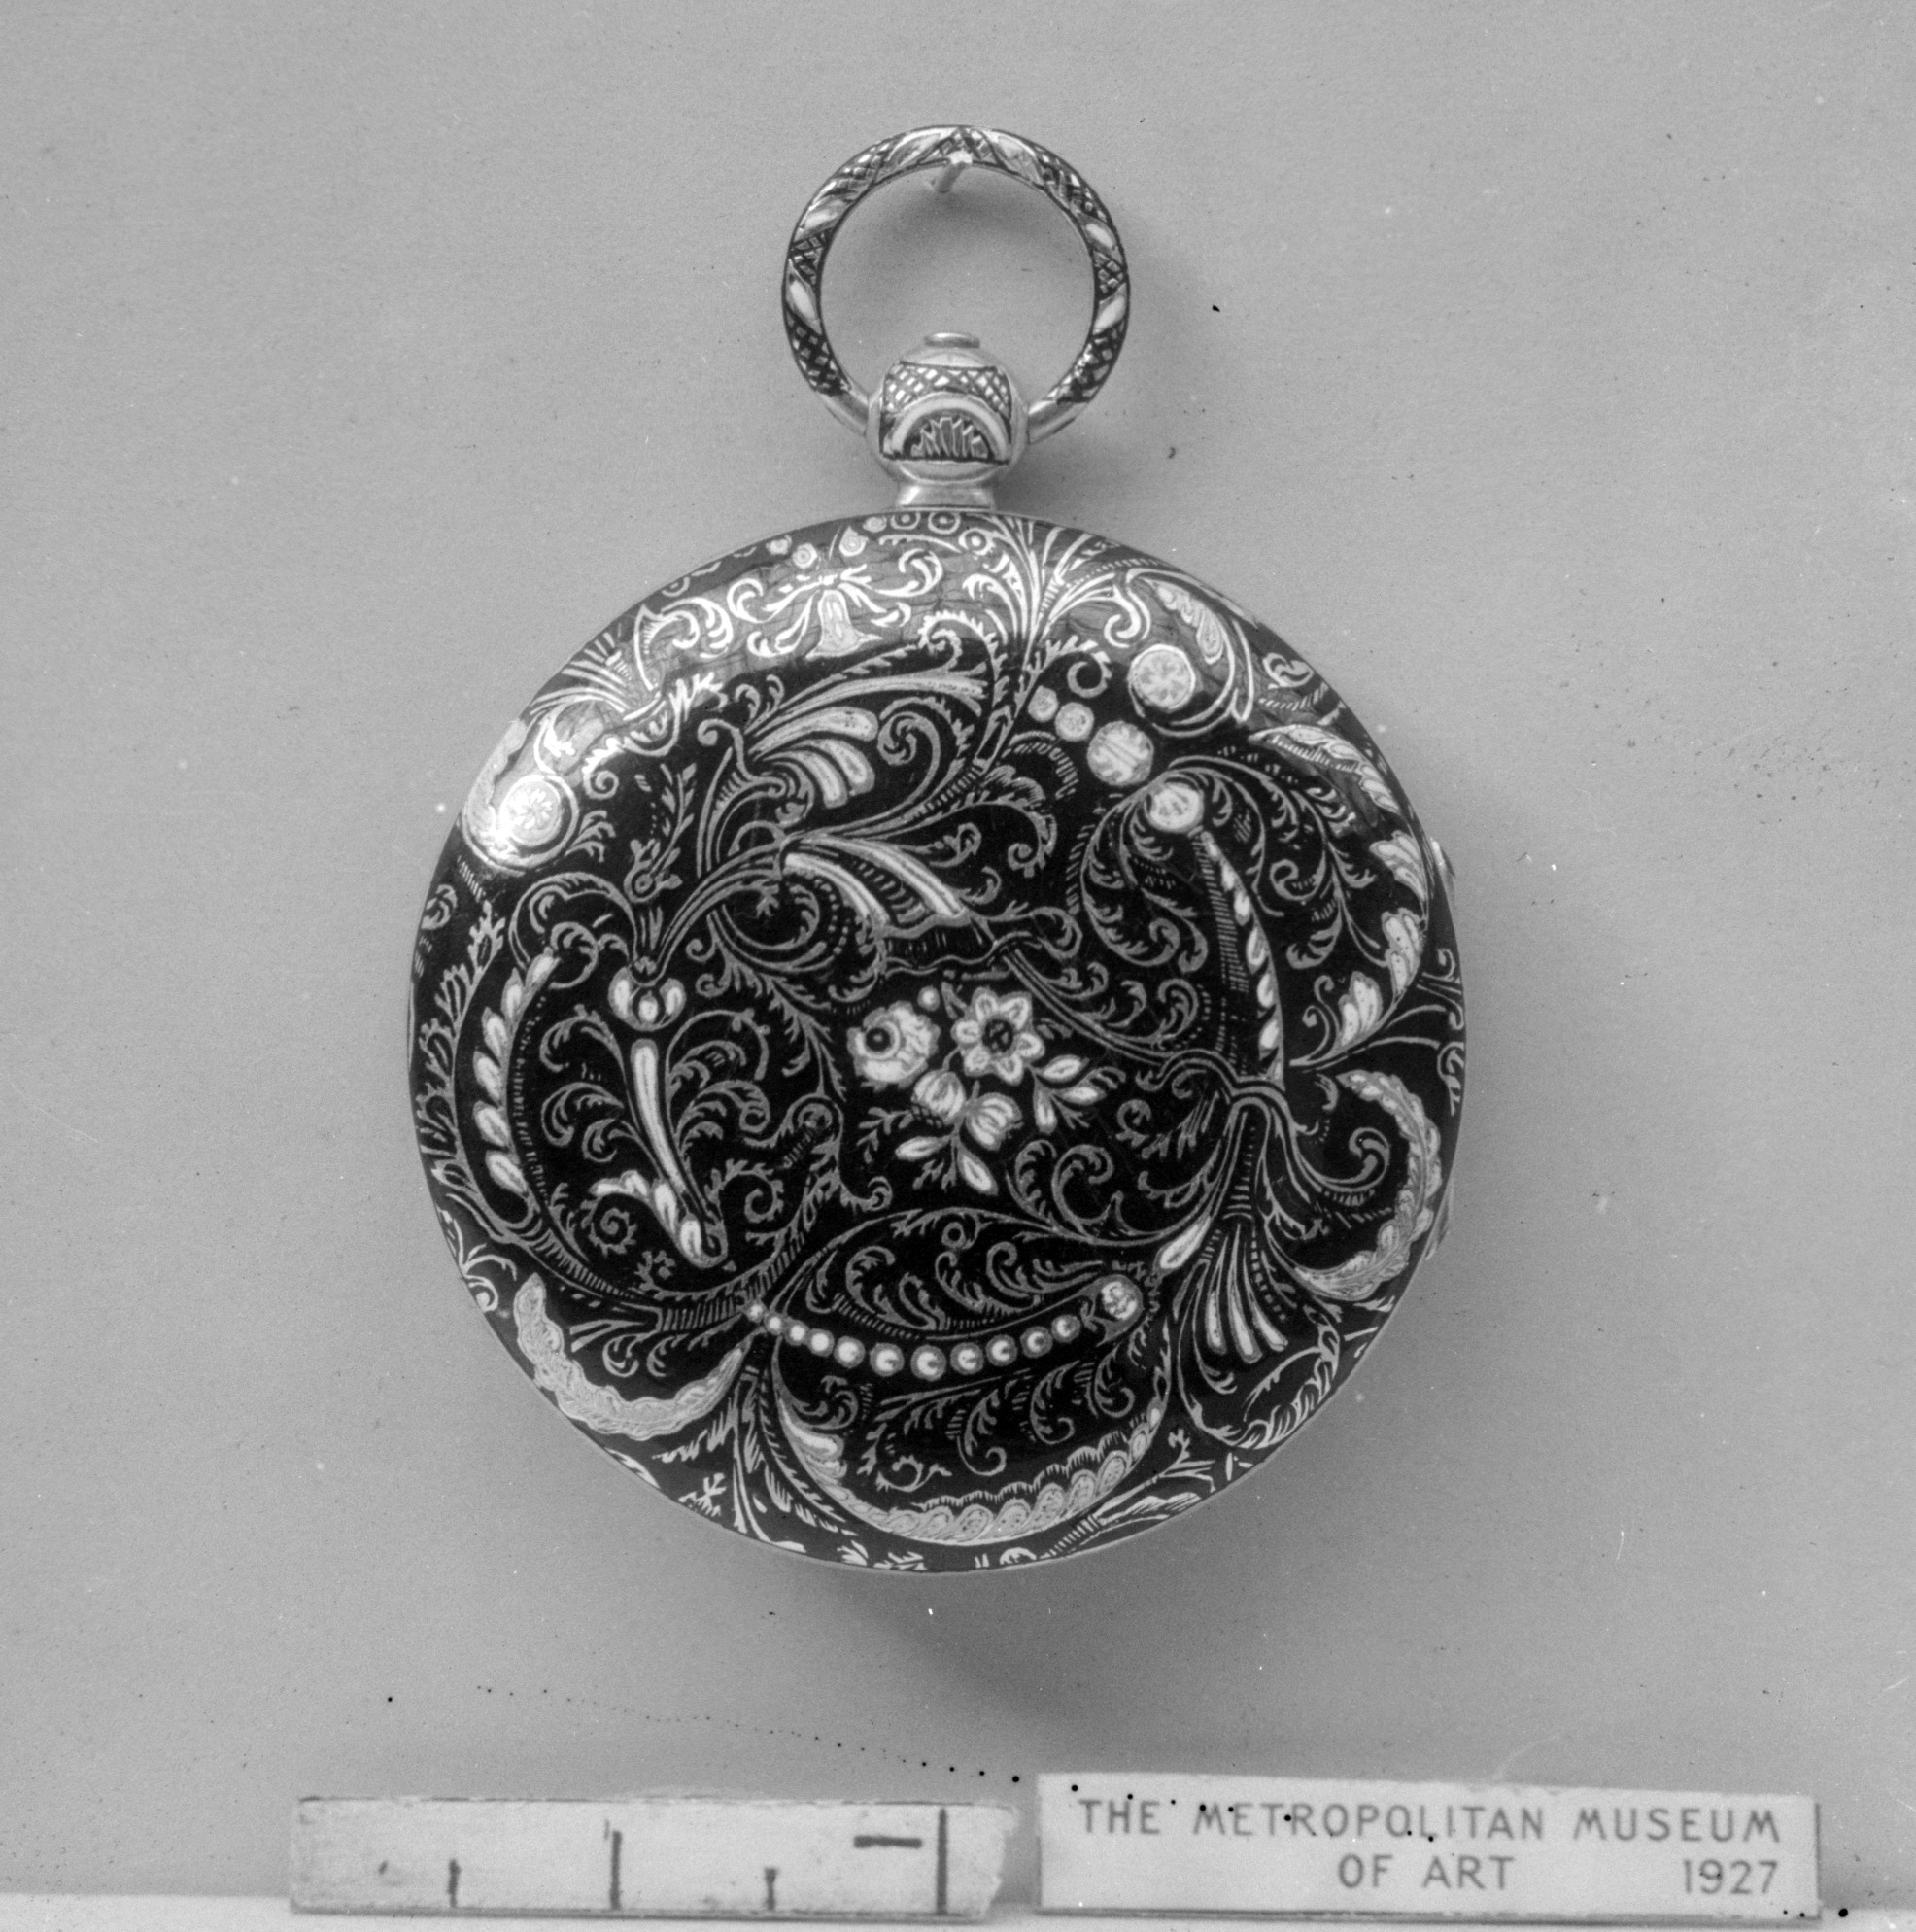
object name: watch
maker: firm of a. meynadier et cie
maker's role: maker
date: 1830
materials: enamel, gold, silver, steel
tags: flowers